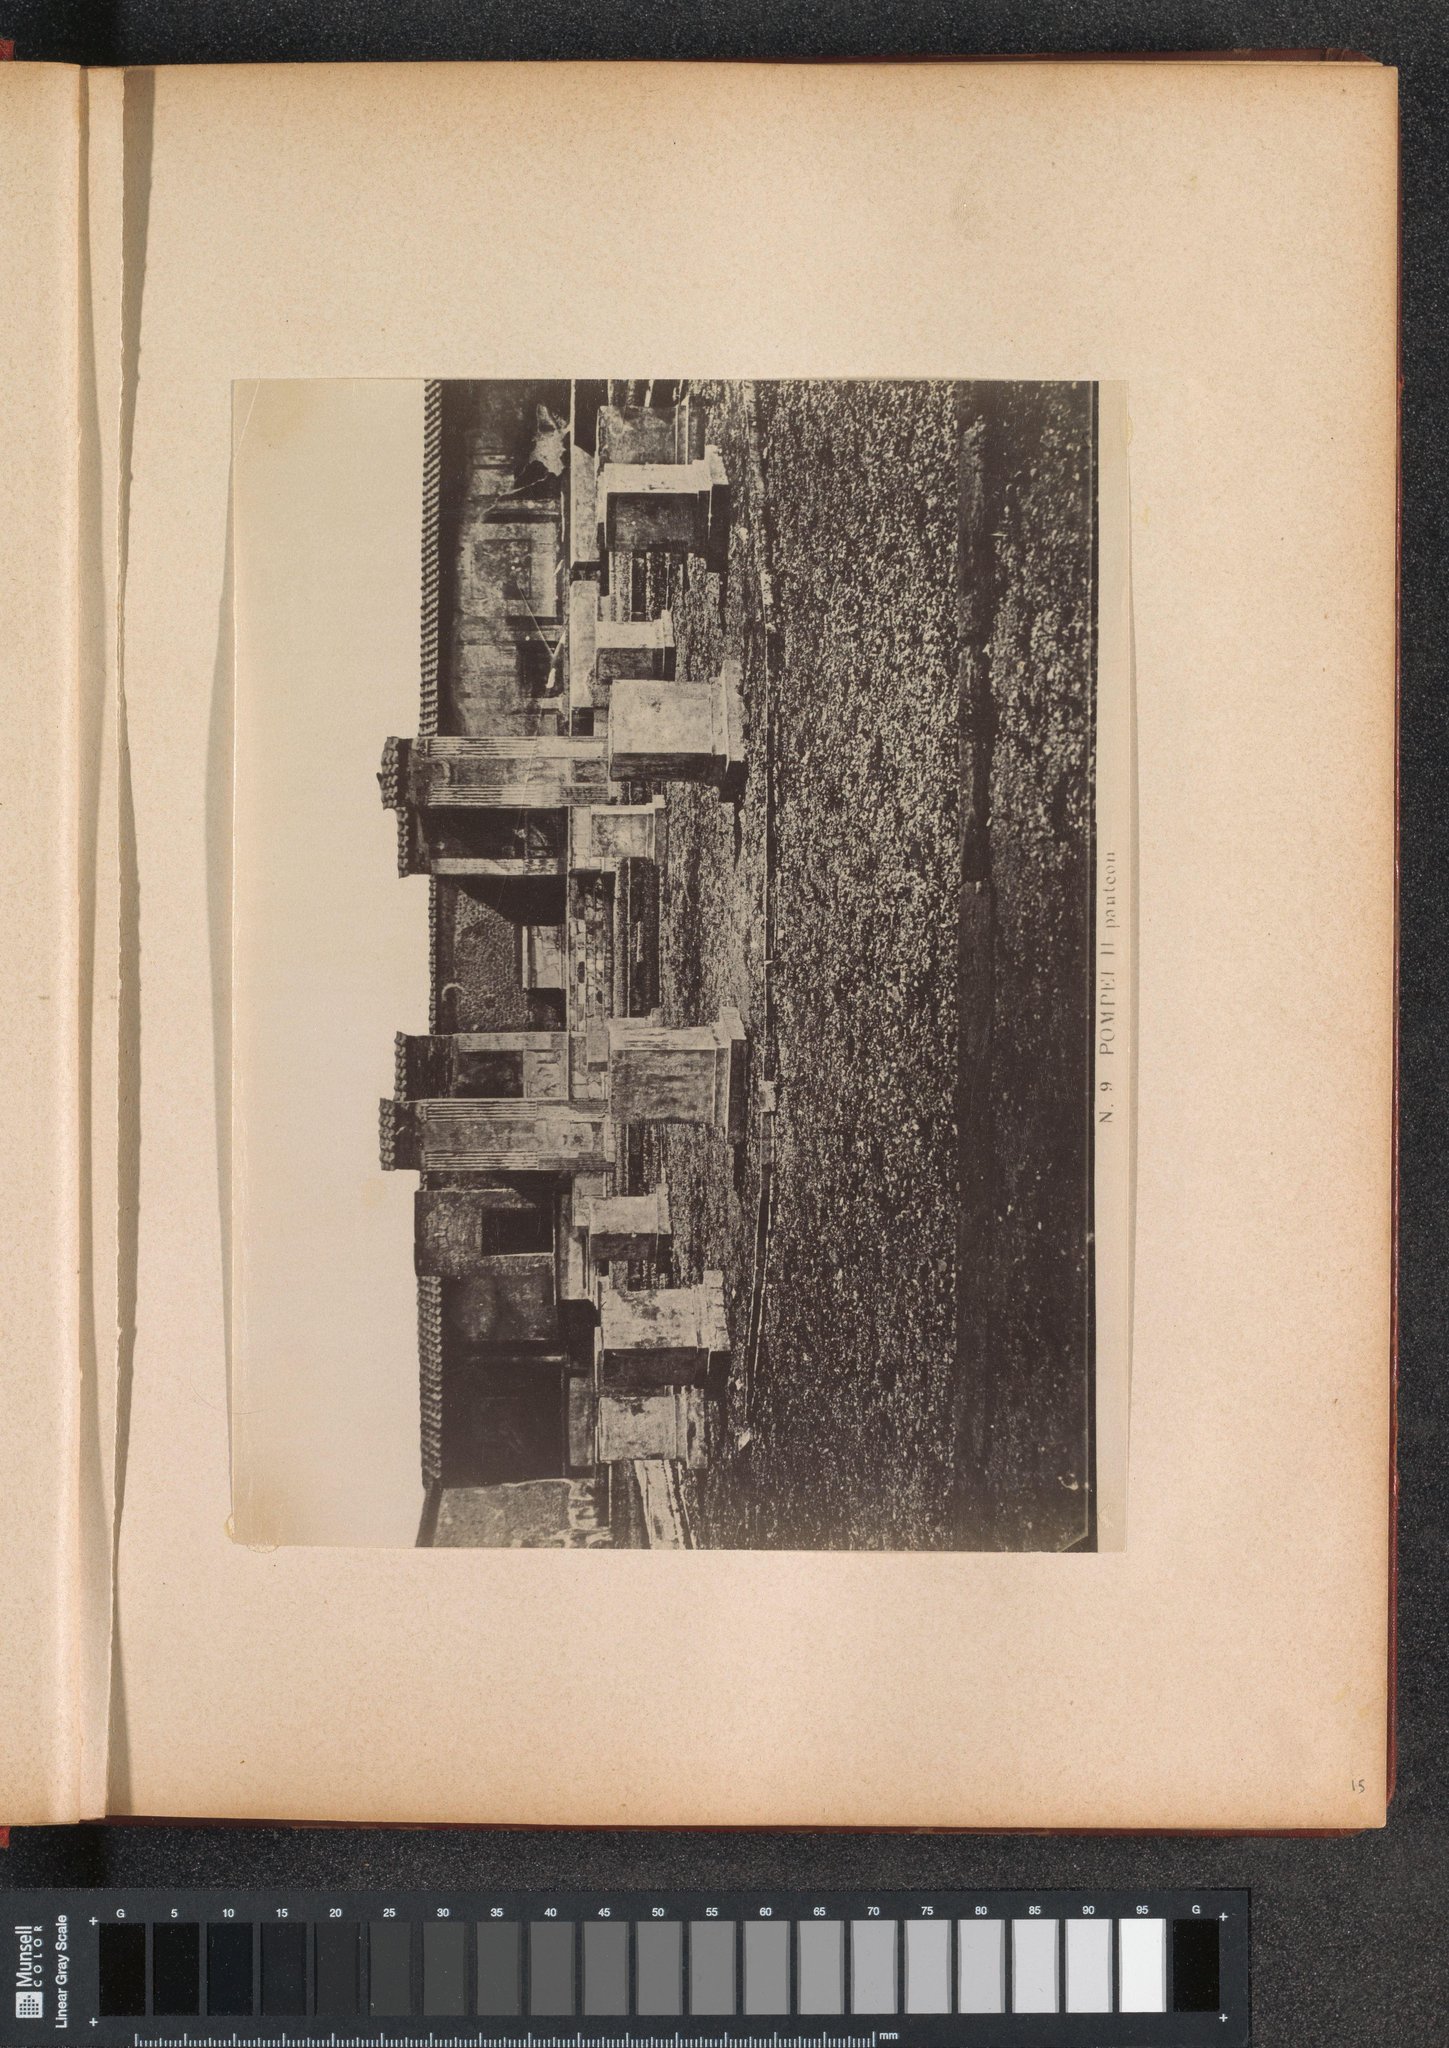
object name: album leaf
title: Restanten van de Tempel van Augustus (Pantheon) in Pompeï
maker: Anonymous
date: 1870-1900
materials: paper, photographic support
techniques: albumen print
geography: pompeii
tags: column, pillar ~ architecture, temple, shrine ~ roman religion, excavation ~ archaeology, pompeii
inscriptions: negative number: ‘9’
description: Onderdeel van Reisalbum met foto's van bezienswaardigheden in Italië en Zuid-Frankrijk.